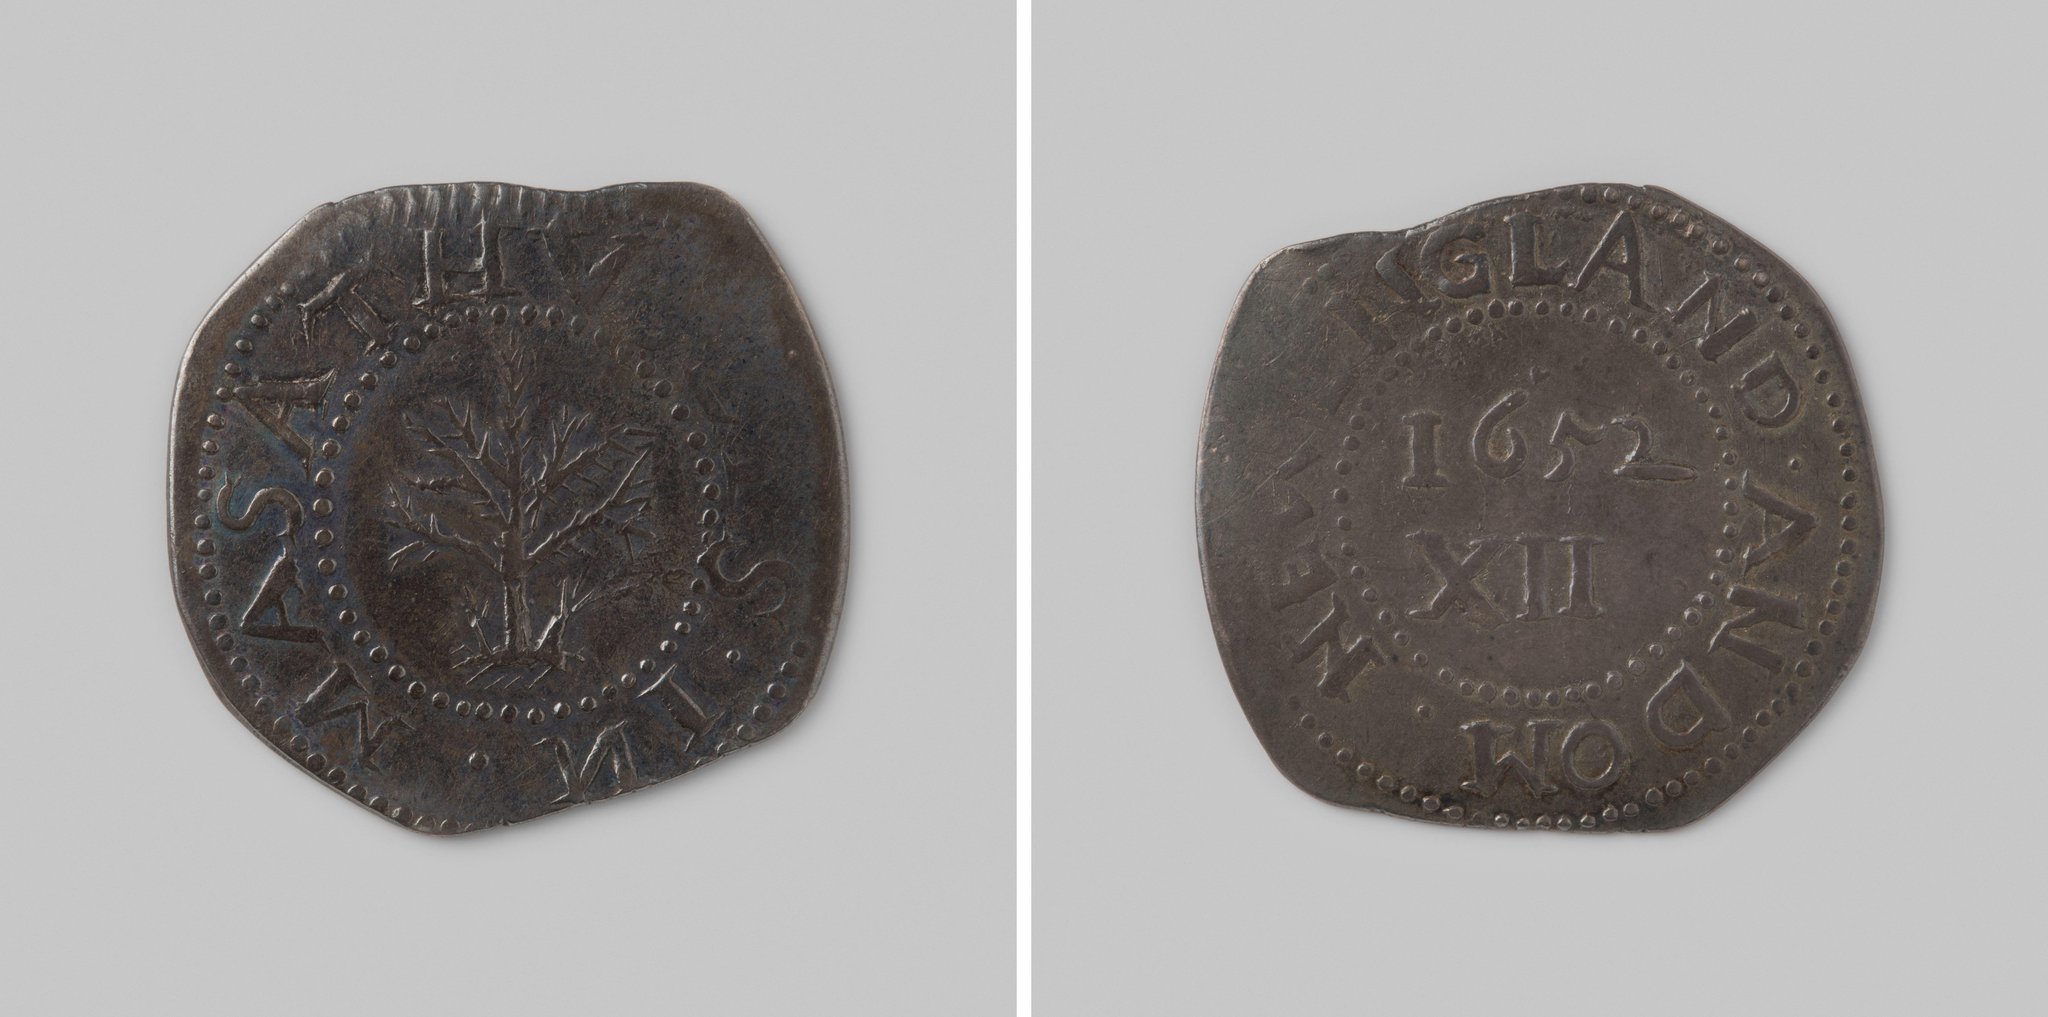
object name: coin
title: Pine tree shilling uit Massachusetts,1652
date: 1652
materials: silver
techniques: striking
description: Zilveren munt. Voorzijde: binnen cirkel van stippen sparreboom. Als omschrift: Masathusets in Keerzijde: binnen cirkel van stippen jaartal: 1652, waaronder waarde-aanduiding: XII [pence]. Als omschrift. new England. An Dom.